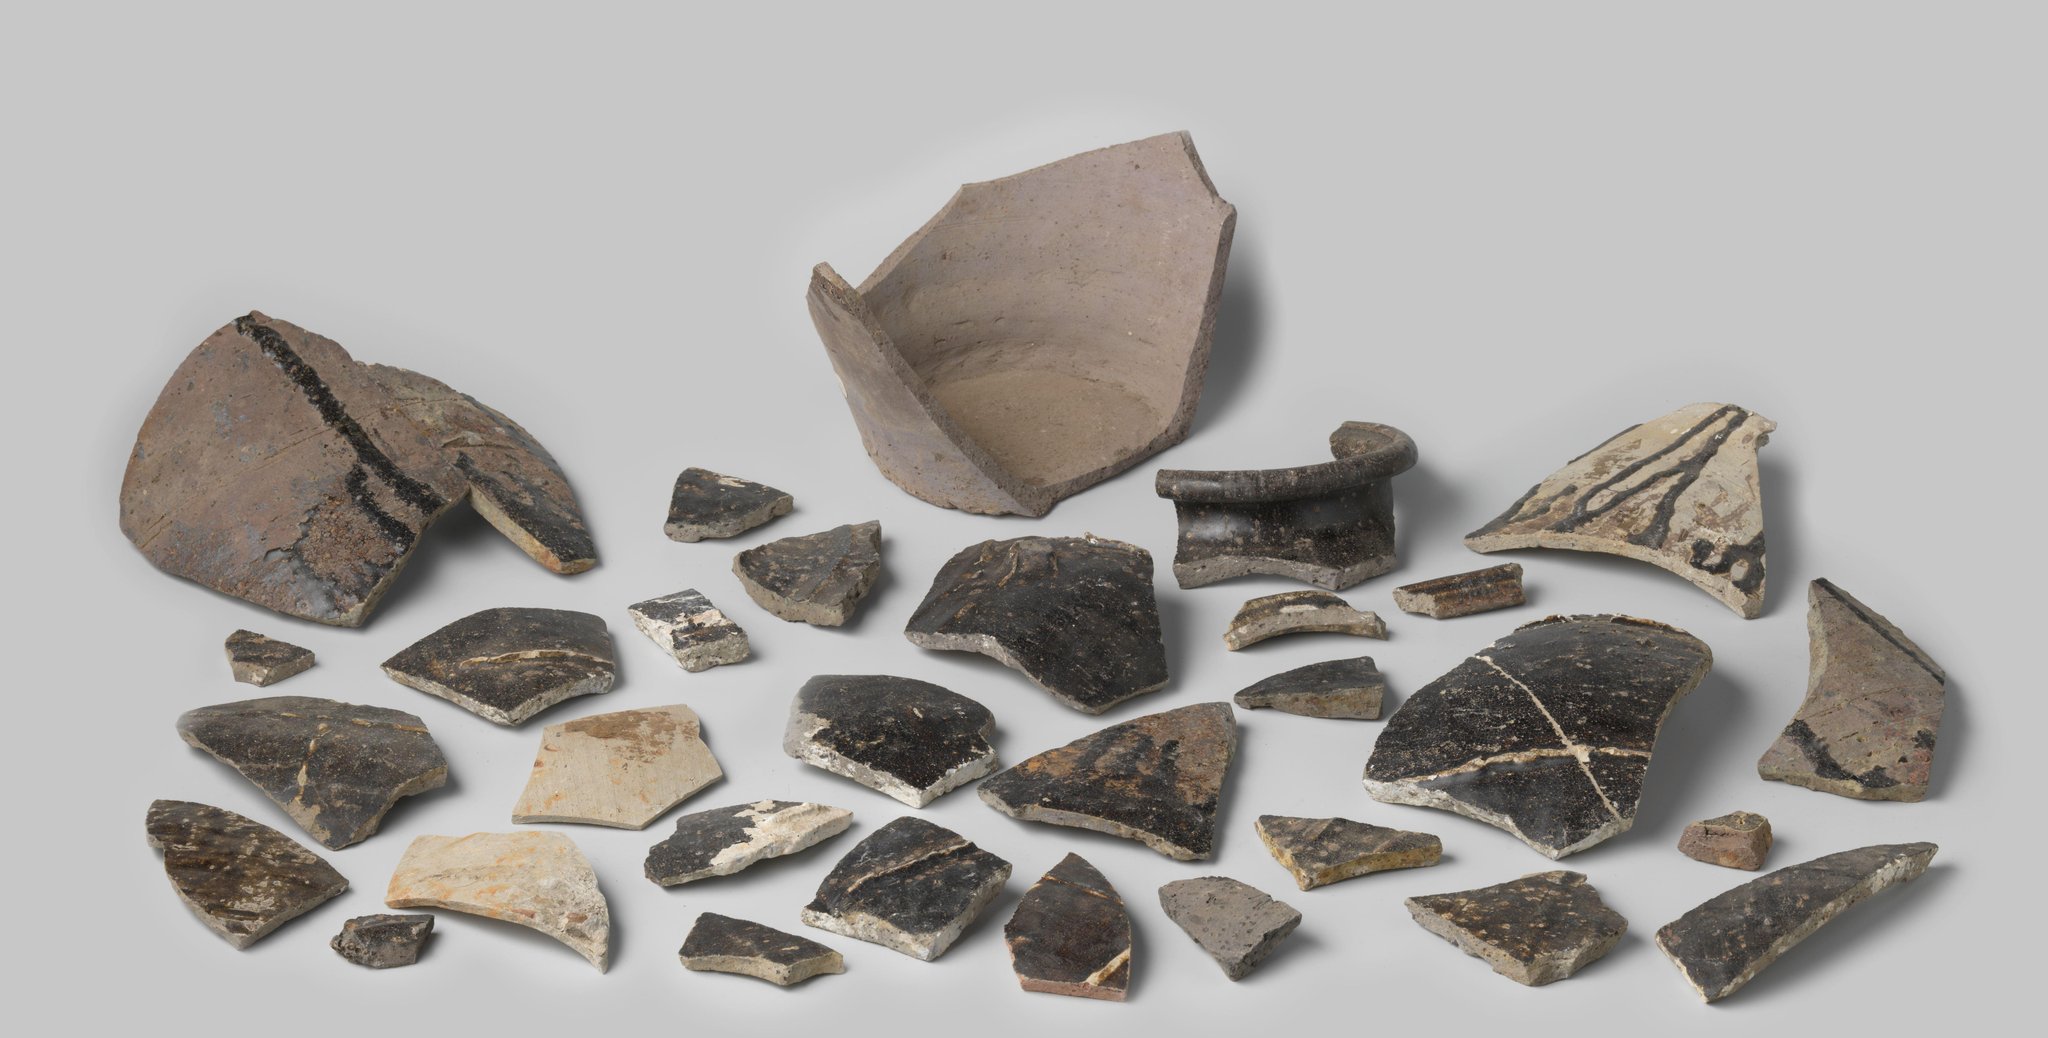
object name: martavaan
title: Scherven van martavanen uit V.O.C.-schip de 'Witte Leeuw'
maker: Anonymous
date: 1613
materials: porcelain, stoneware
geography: martaban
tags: verenigde oostindische compagnie, sint-helena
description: A jar. The upper part of the jar is glazed and long trickles run down. On the inside, the lip, neck and shoulders joint are glazed. Between the neck and shoulder, there is an unbroken dotted band. From this band vertical bands run down halfway the body. The jar has been made in two parts, of which the lower part is smaller.